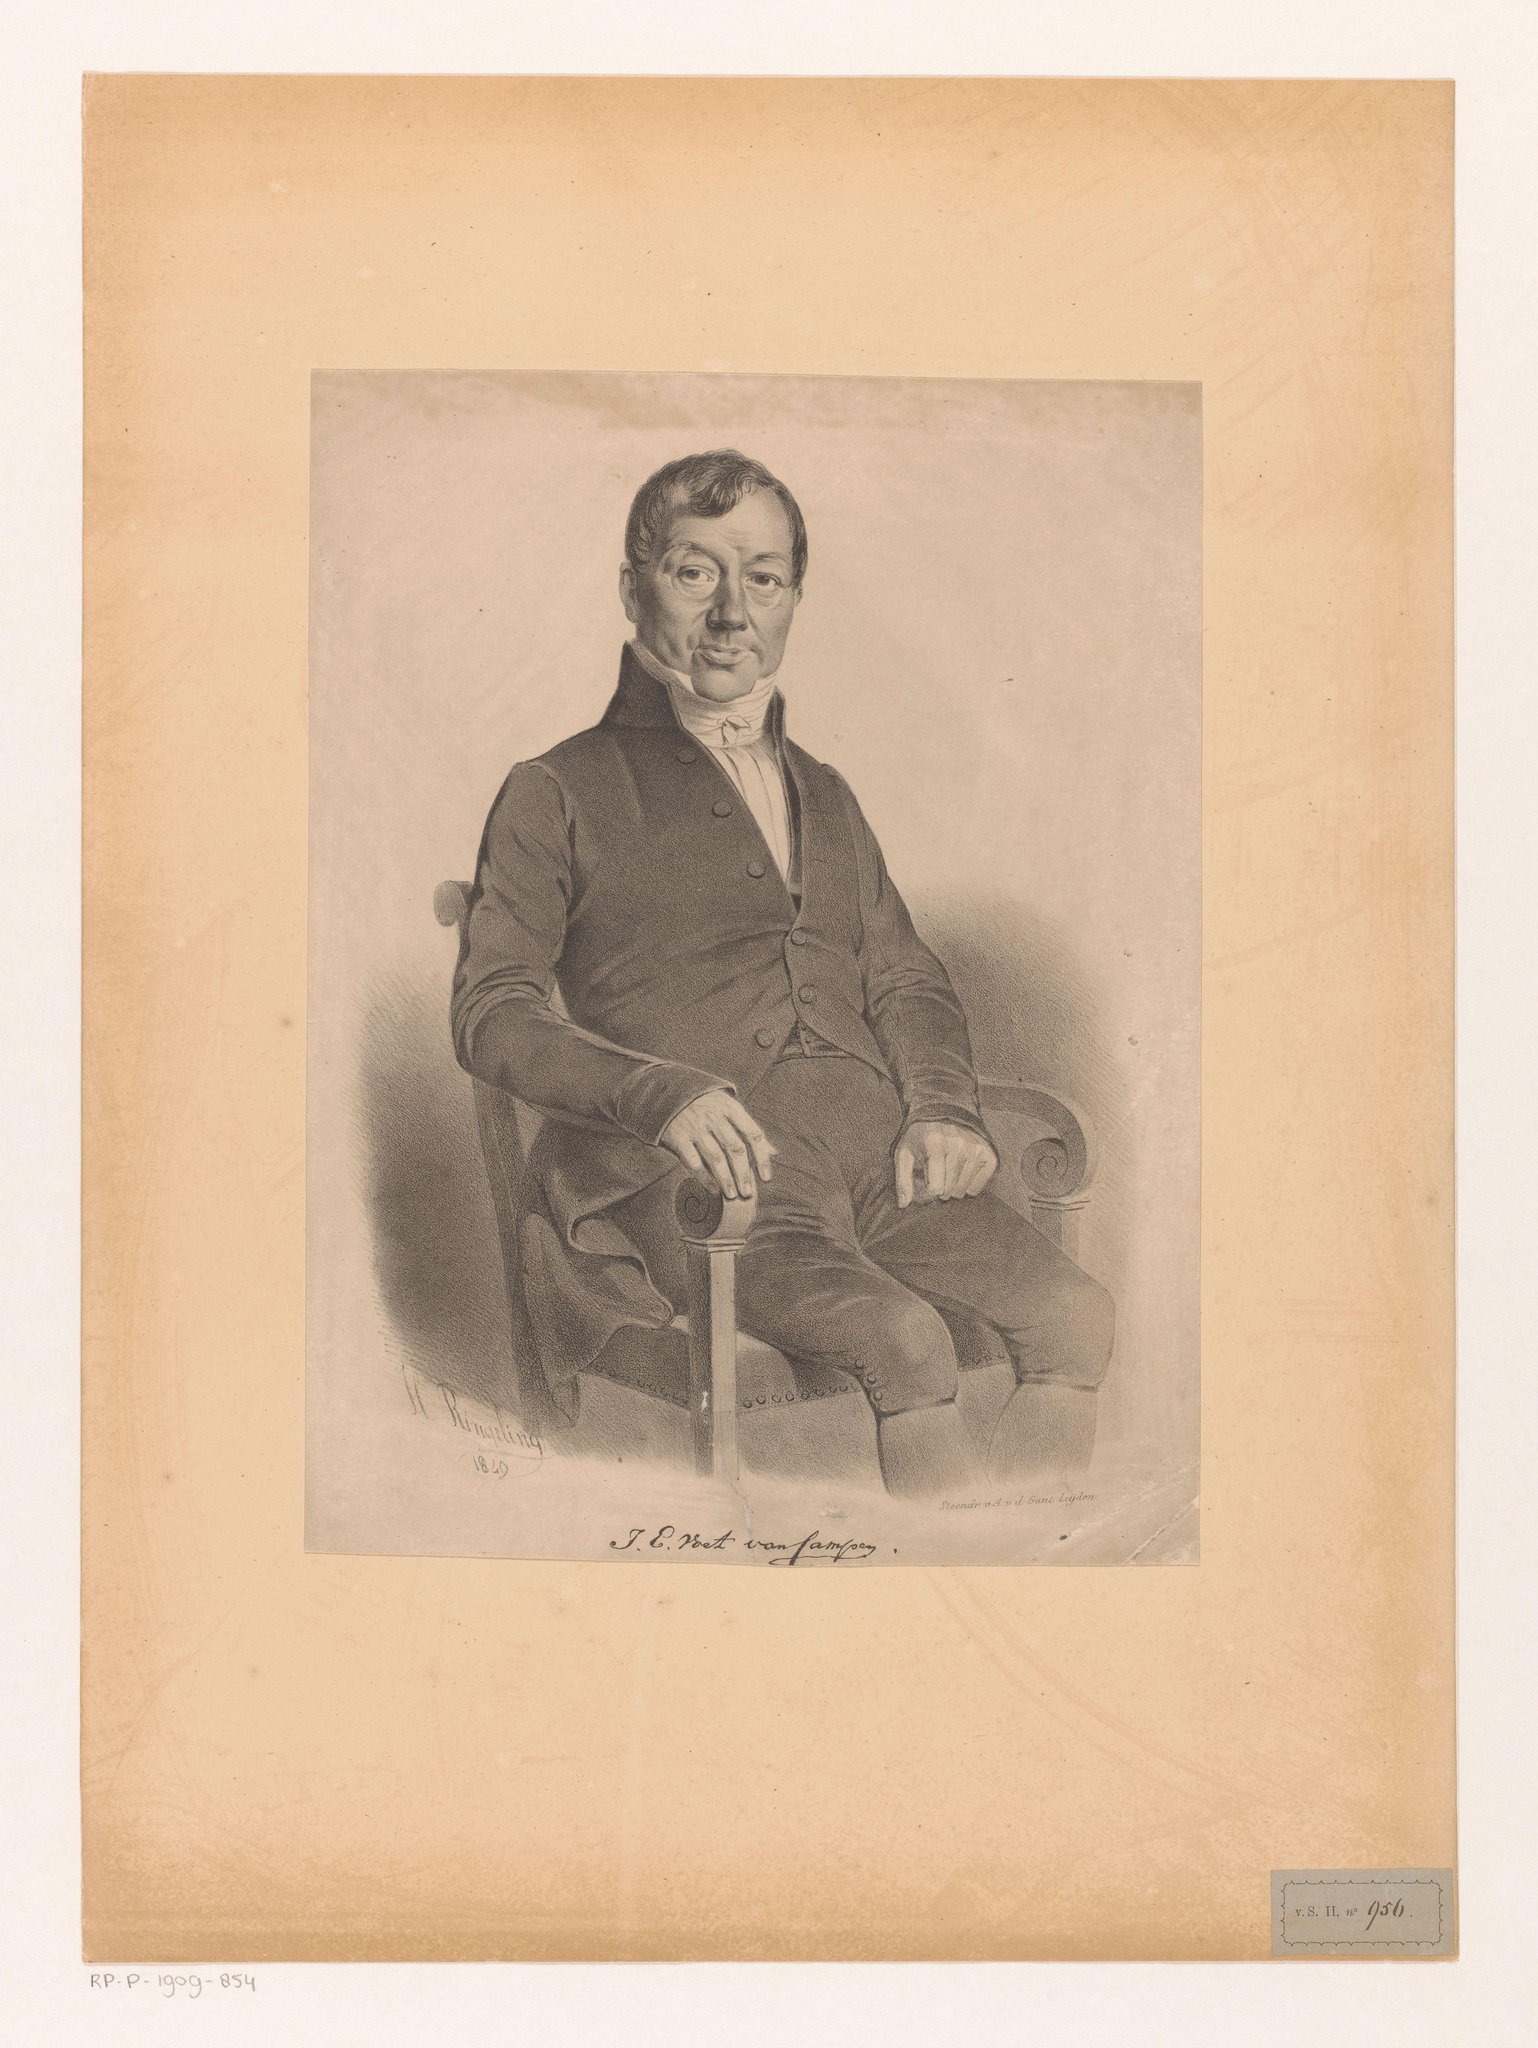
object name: print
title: Portret van J.E. Voet van Campen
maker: arie van der gant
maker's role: printer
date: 1849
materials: paper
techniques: lithograph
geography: leiden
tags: leiden, print maker, historical persons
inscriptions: collector's mark: Lugt 2228